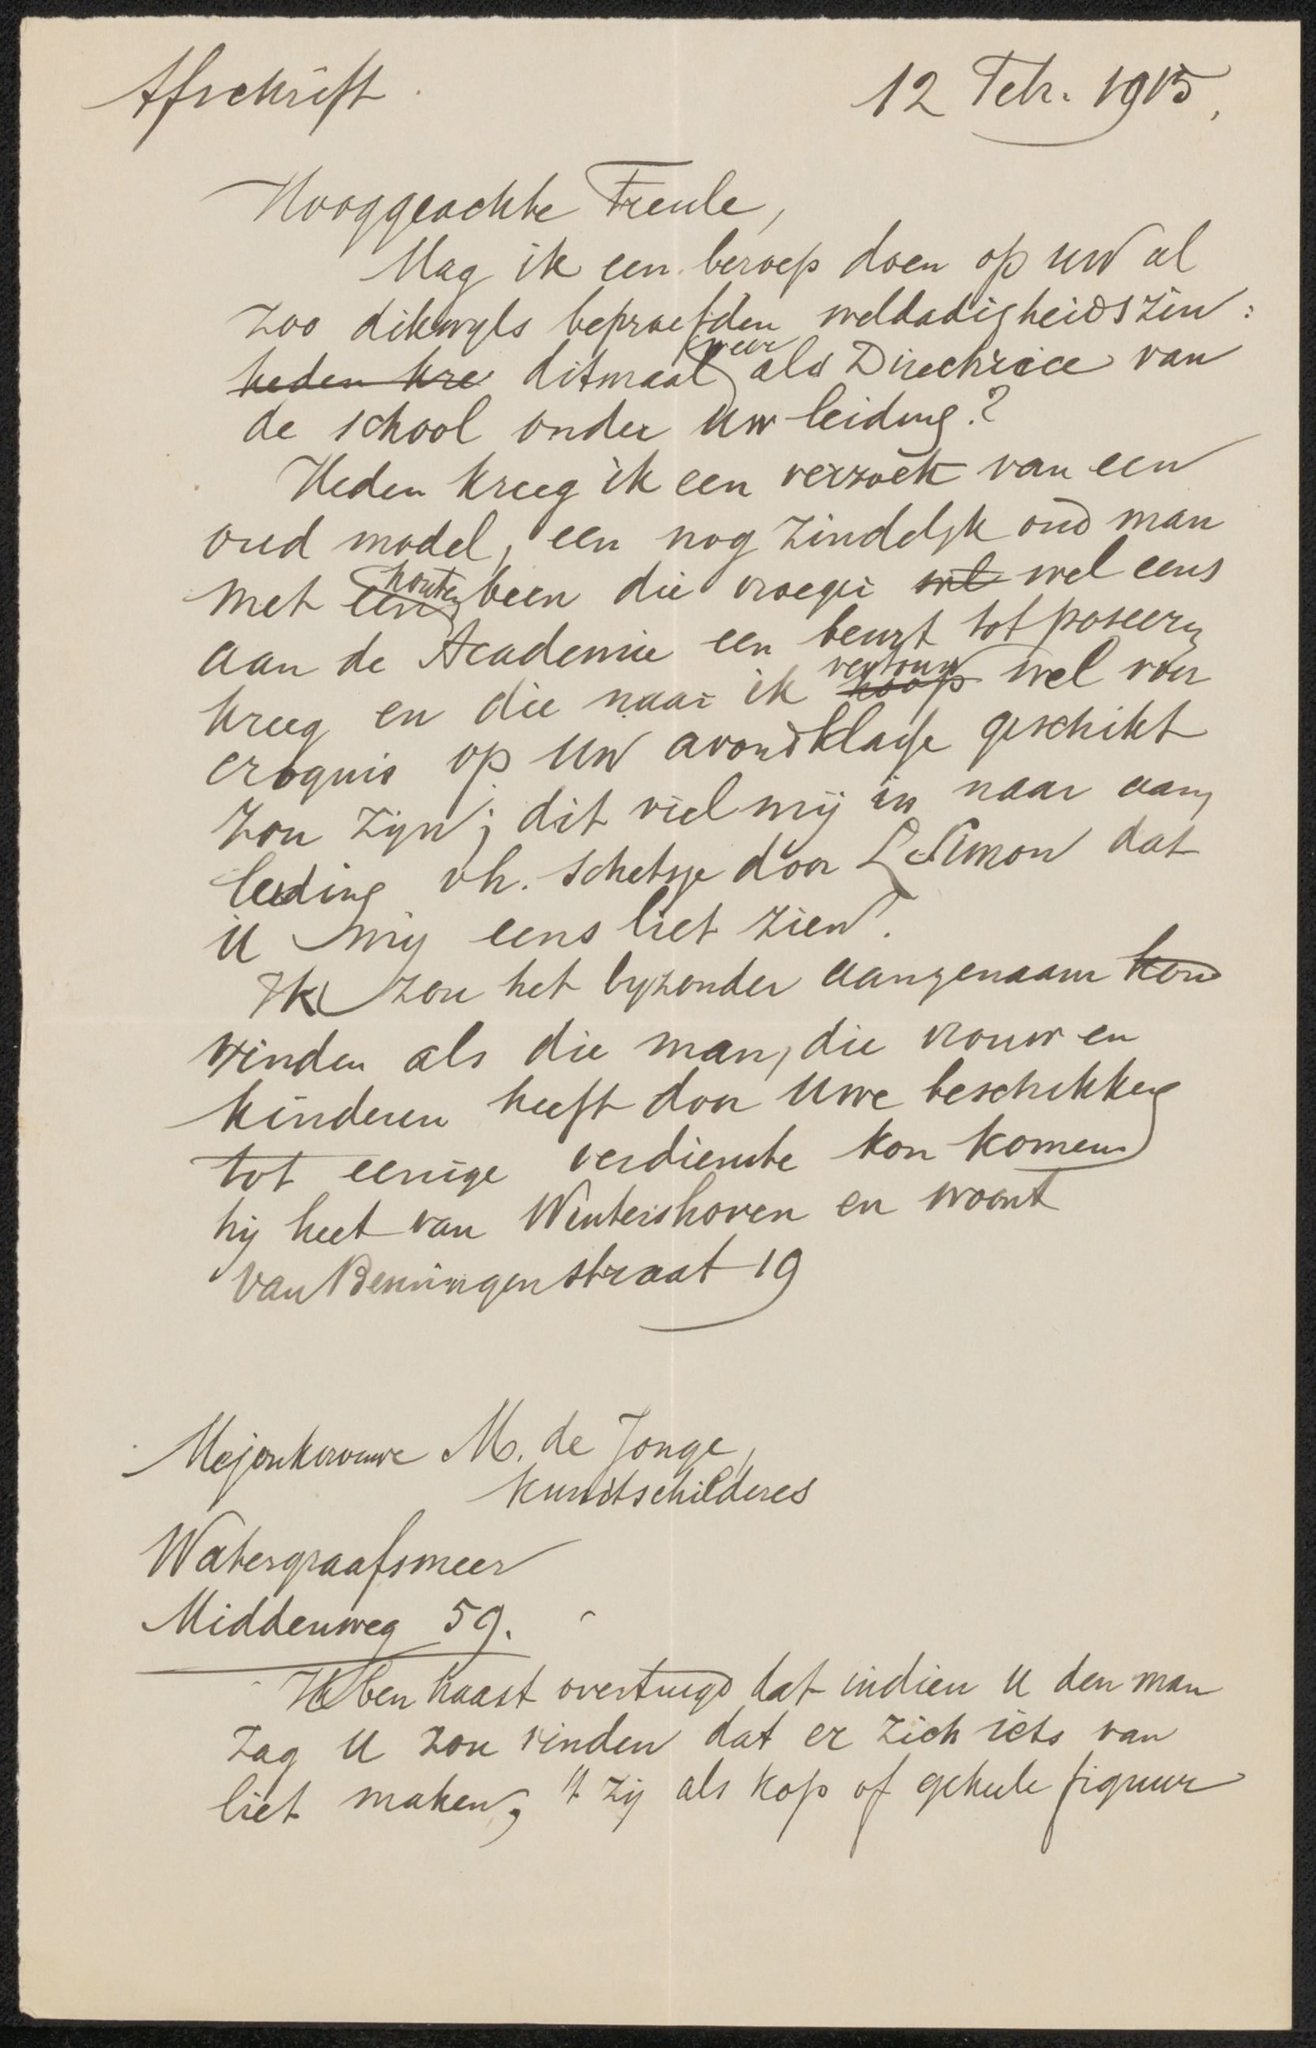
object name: letter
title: Brief aan Marie de Jonge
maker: august allebé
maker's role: draughtsman, print maker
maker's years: 1838-1927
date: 1915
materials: ink, paper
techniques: pen, writing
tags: painter, draughtsman, artist's model, sitter, education, tuition of the artist (in general)